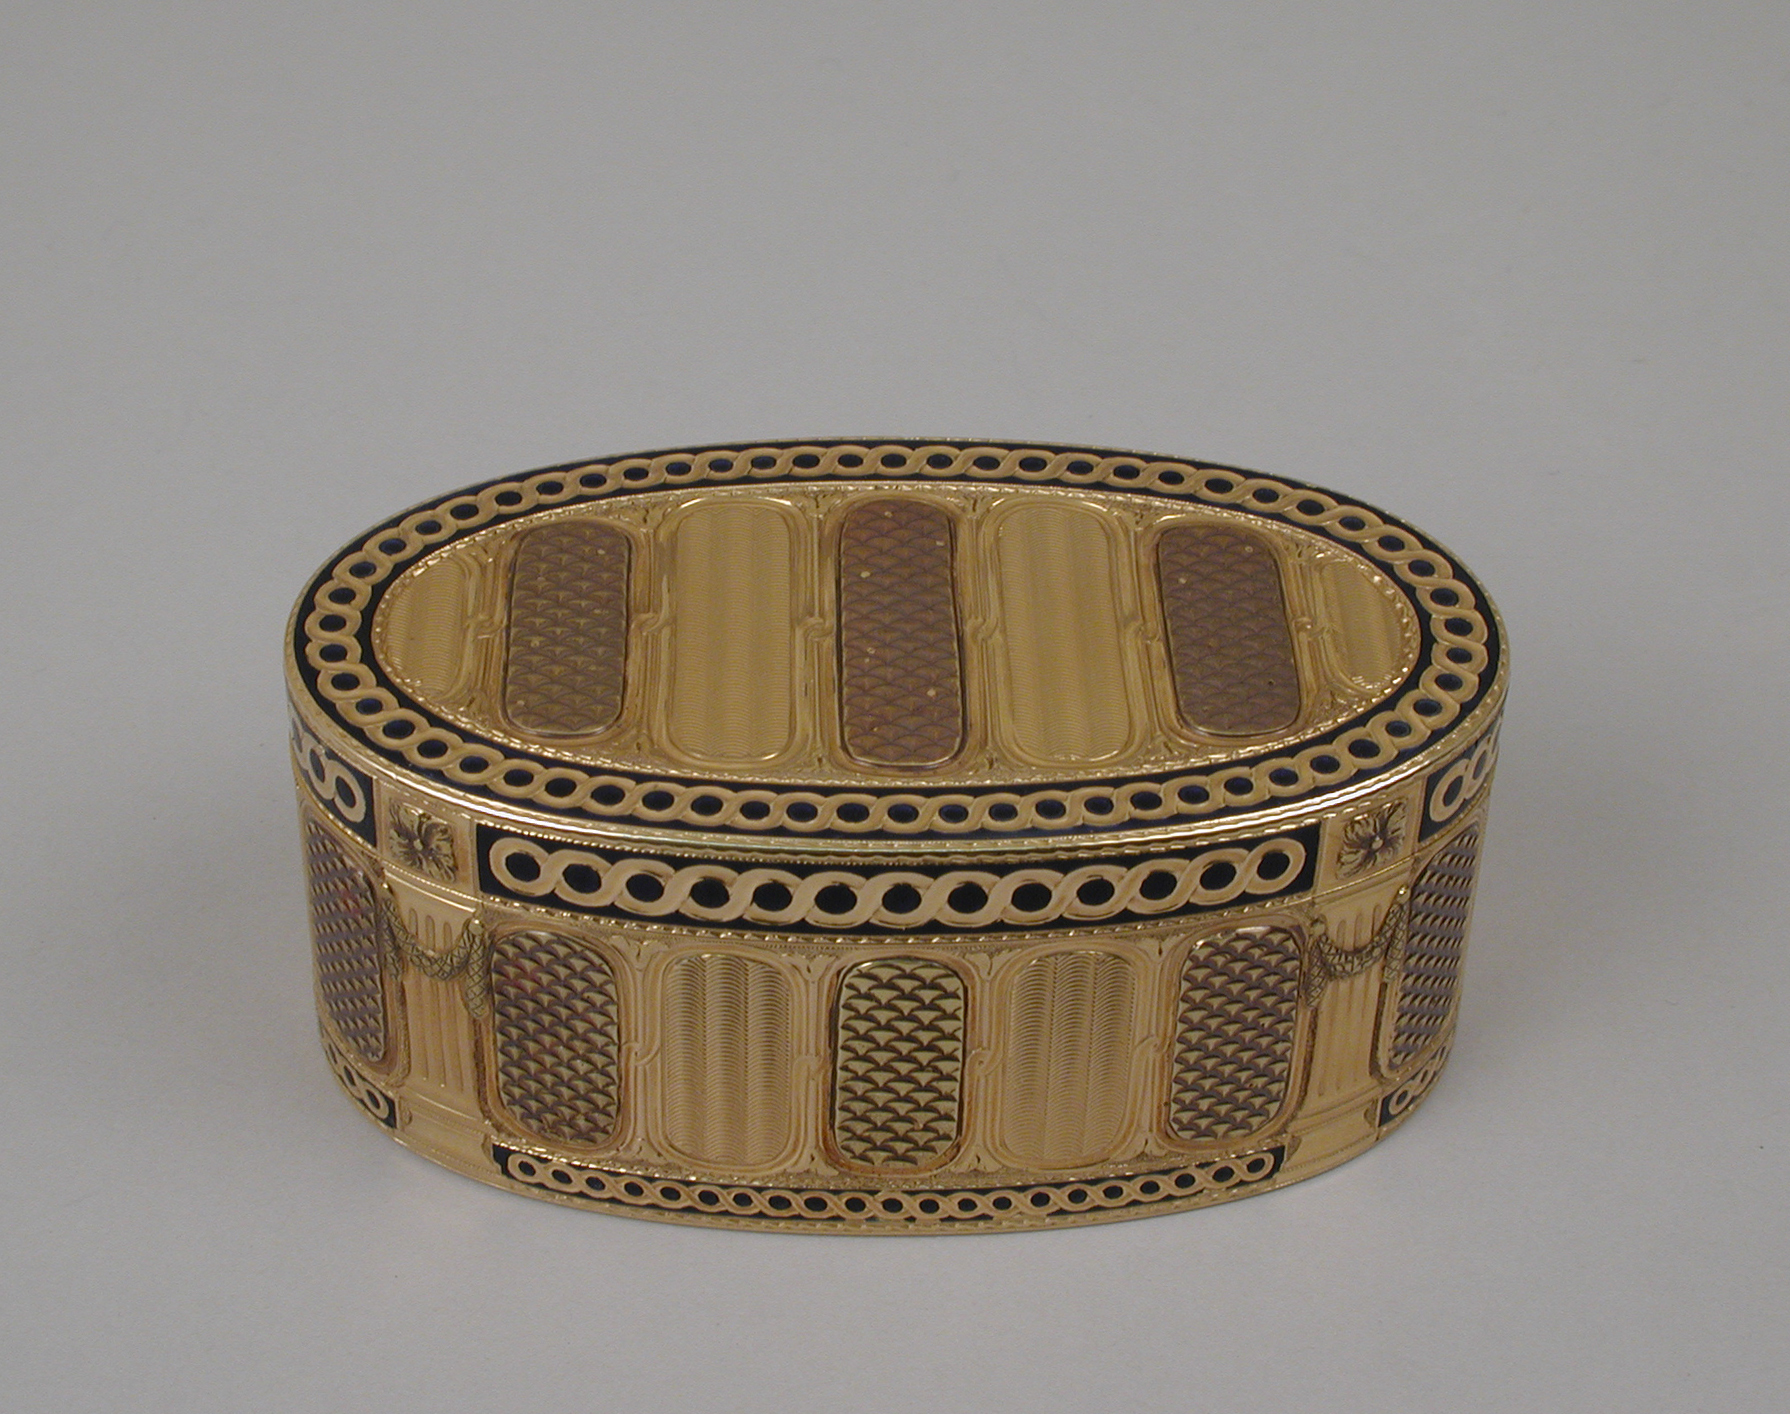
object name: snuffbox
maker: philippe-emanuel garbe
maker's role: maker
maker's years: 1707-1823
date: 1762-1763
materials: enamel, gold